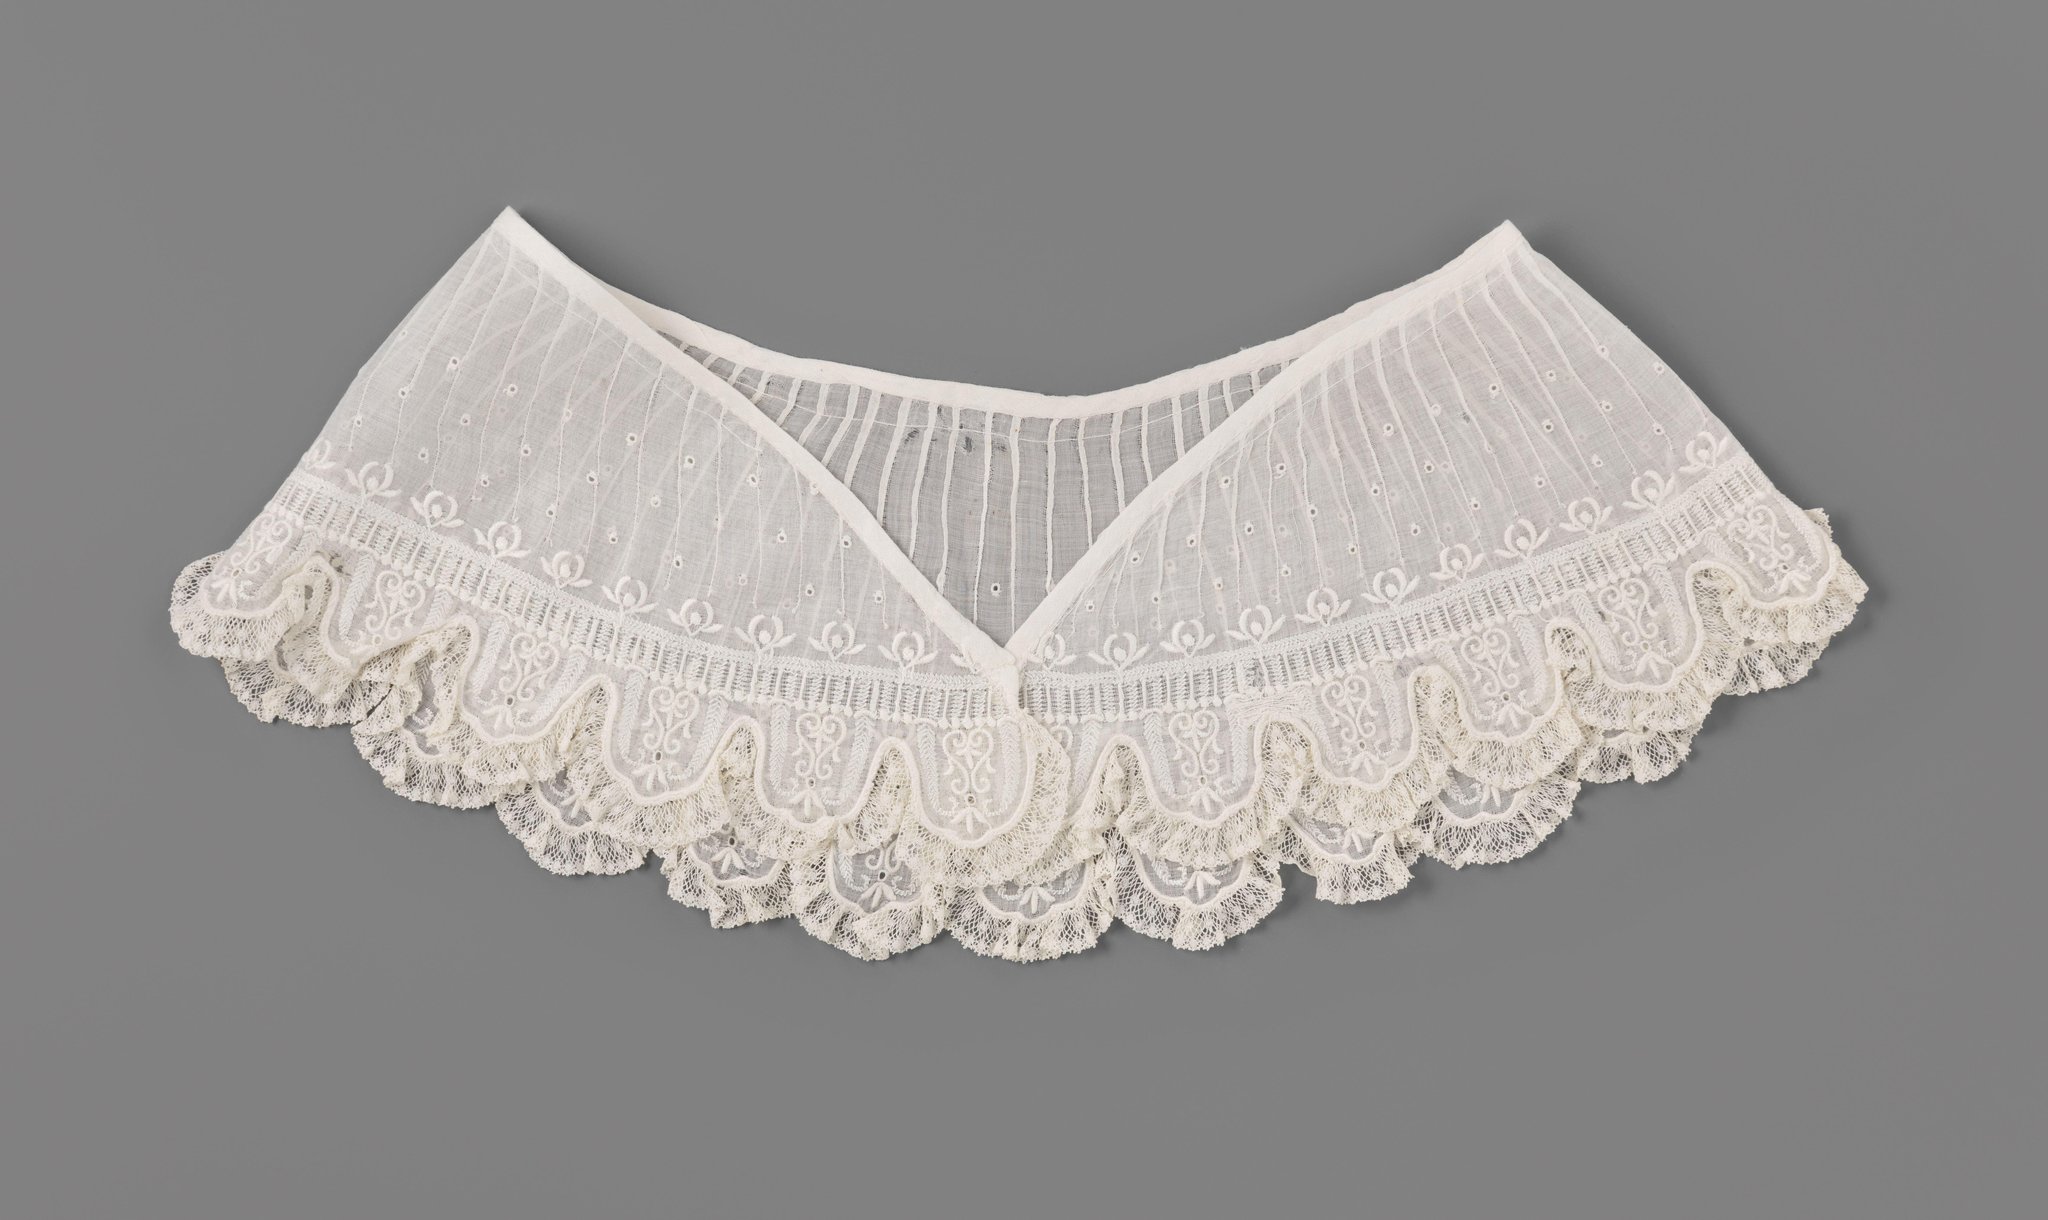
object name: womenswear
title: Sjaalkraag van neteldoek met geborduurde schulpen afgezet met een strook Valenciennes-kant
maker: Anonymous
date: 1800-1825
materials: textile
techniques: lace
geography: western europe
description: Shawlkraag van neteldoek met geborduurde schulpen en een Valenciennetje. Model. Korte shawlkraag met oprijgjes. Diepe schulpen. Manchetjes. Cylmtrisch, zonder oprijgjes en kant. Borduurwork. Plumetisborduursel met blaadjesrand en in elke schulp een palmetmotief tussen veertjes.